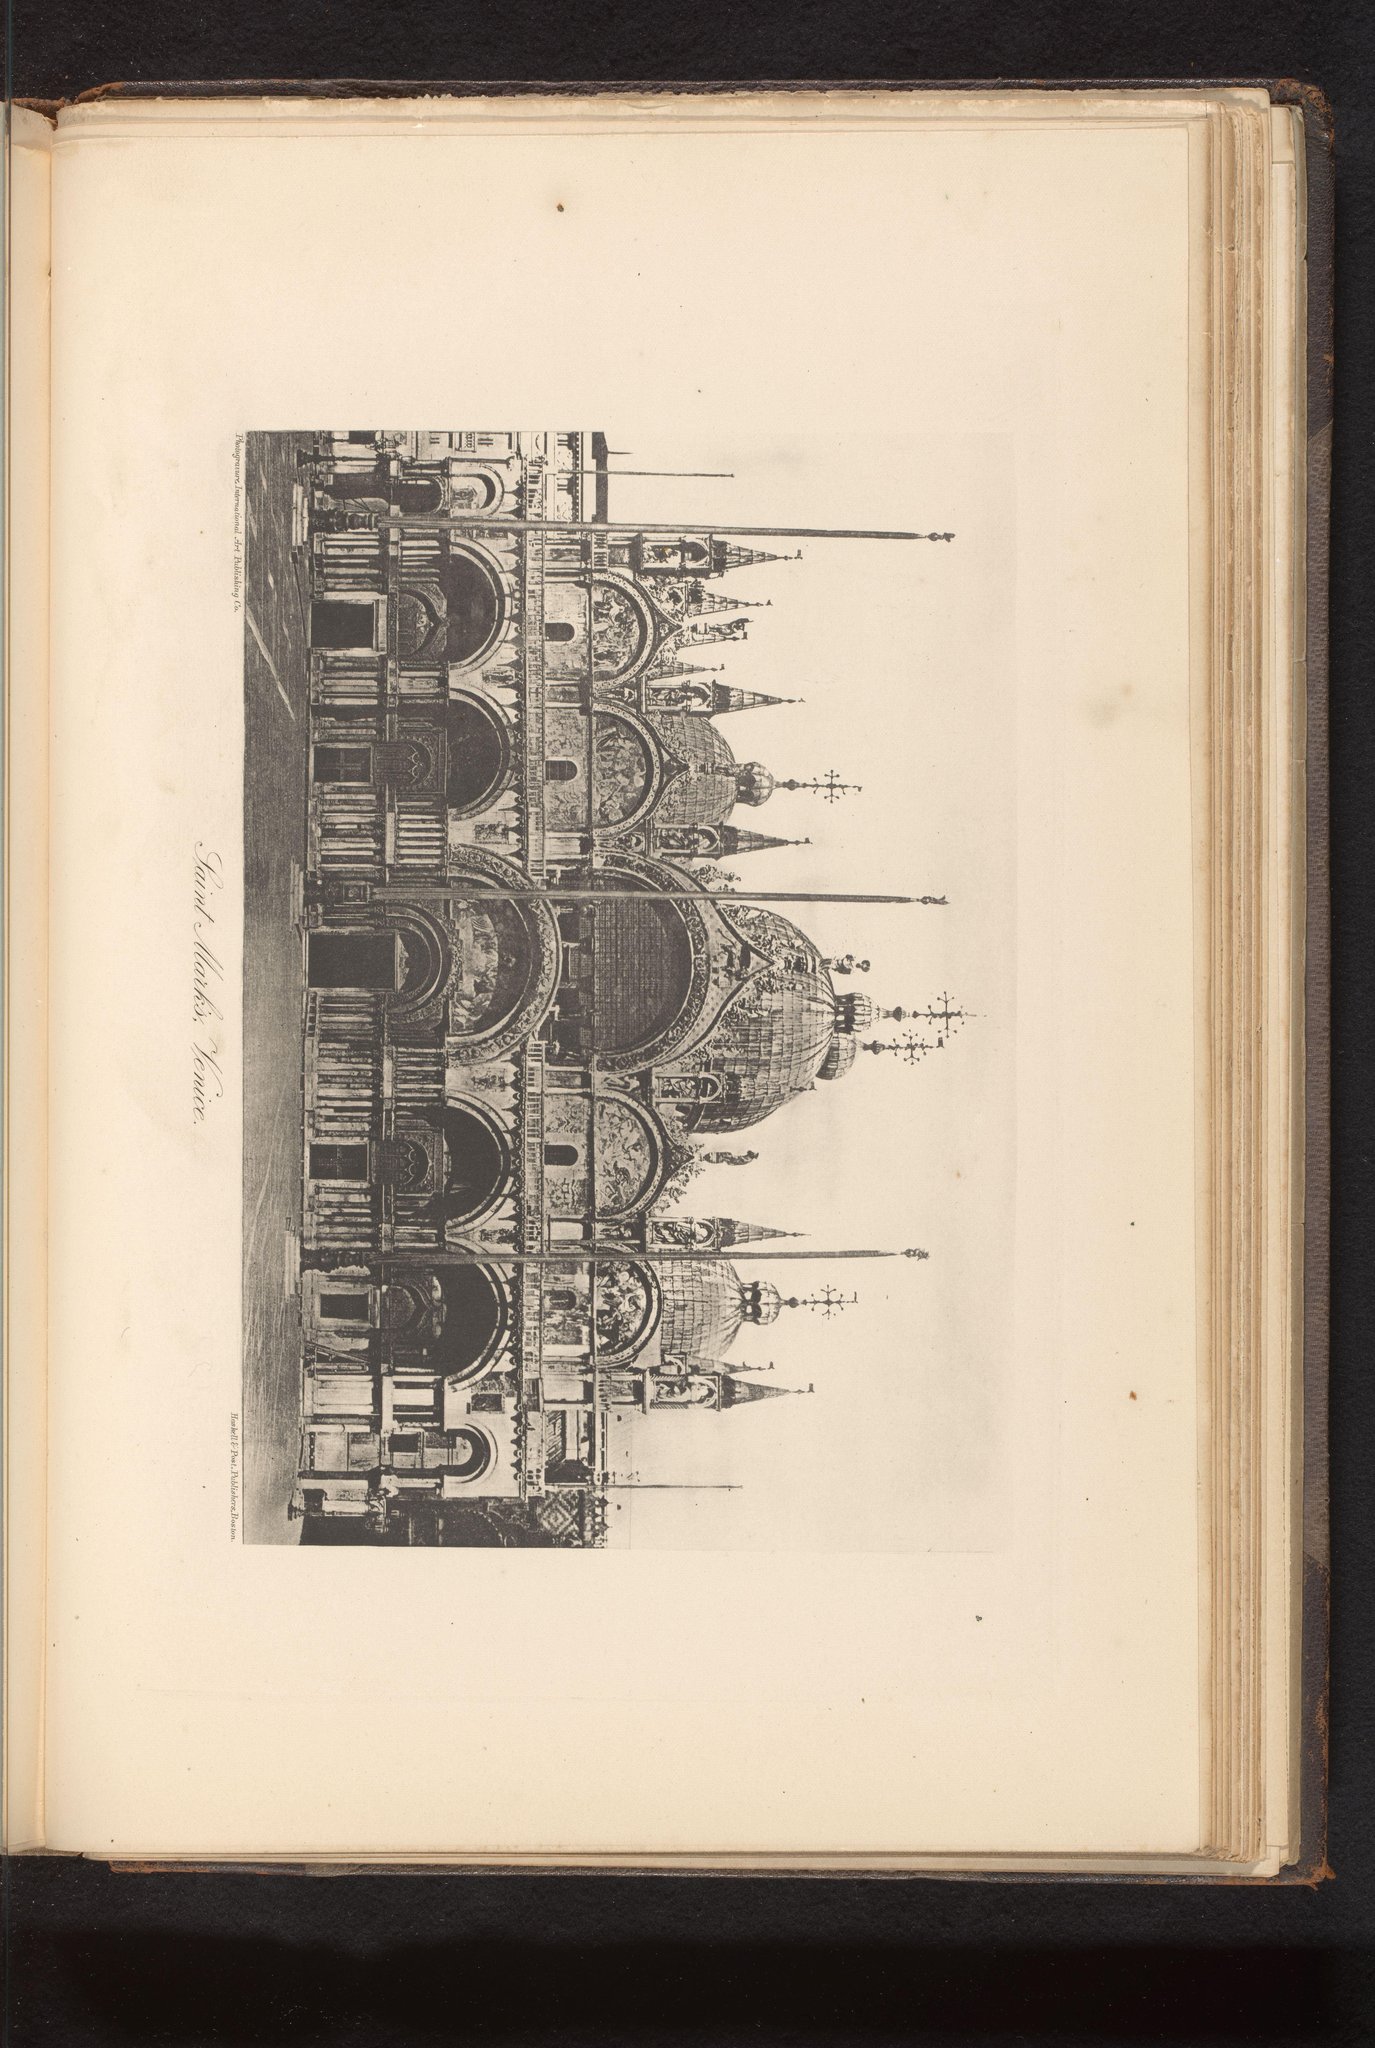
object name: photomechanical print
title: Gezicht op de Basiliek van San Marco te Venetië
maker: Anonymous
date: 1881-1886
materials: paper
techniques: photograph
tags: church (exterior)